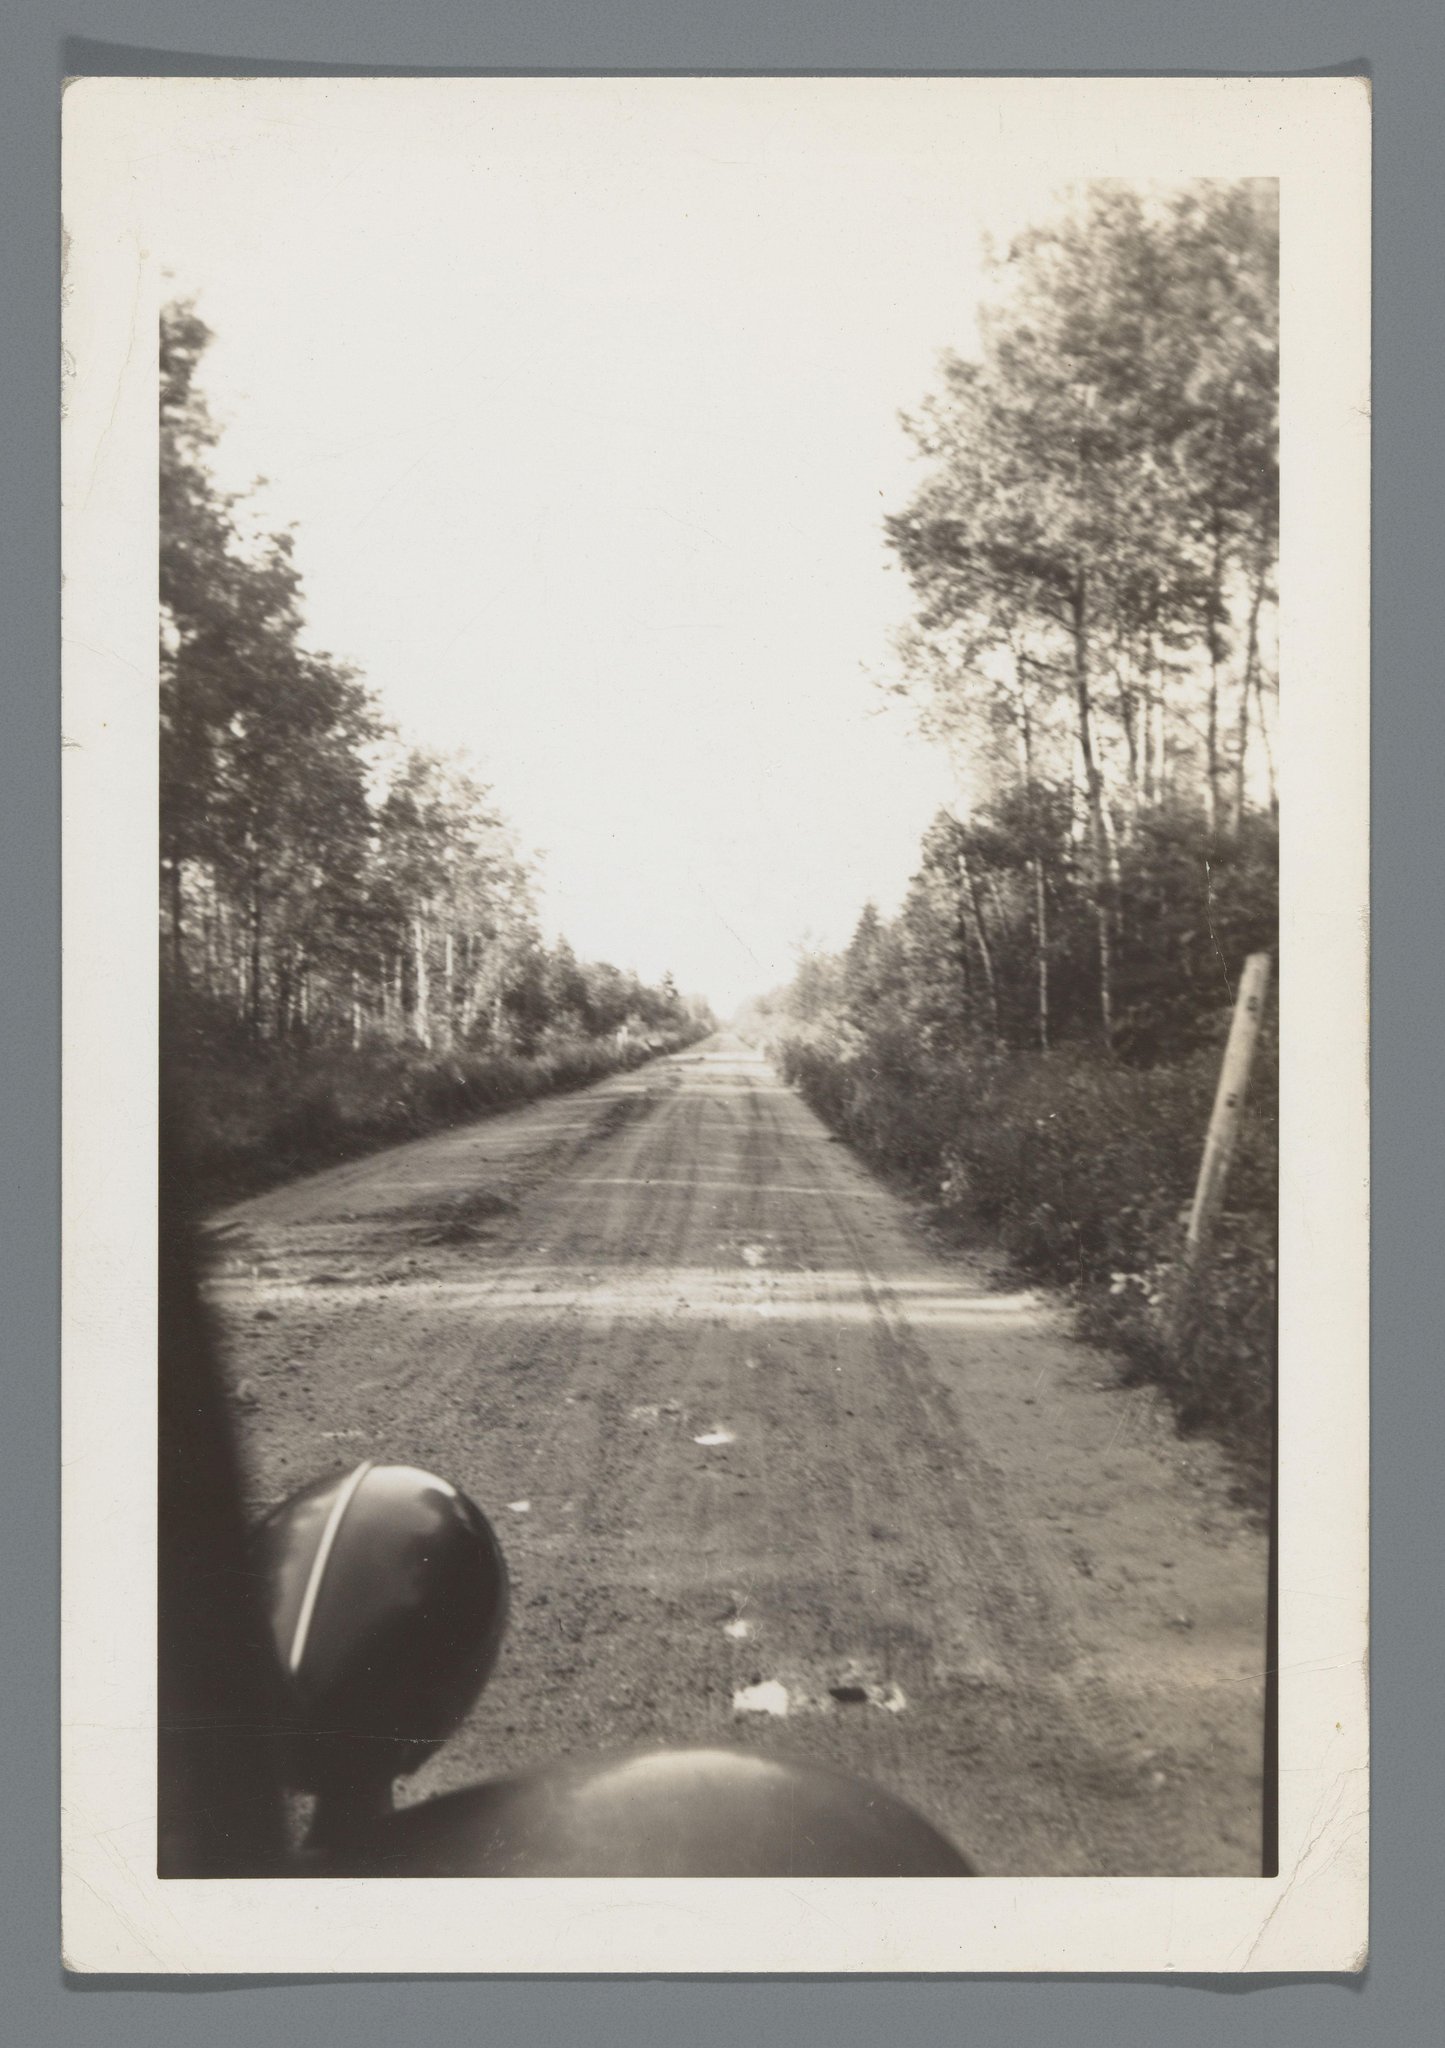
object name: photograph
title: Gezicht vanuit een rijdende auto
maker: Anonymous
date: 1908-1940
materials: paper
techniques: gelatin silver print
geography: united states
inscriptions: inscription: ‘Look close the/ deer or Dear is/ there.’, inscription: ‘911F’, inscription: ‘[…] AUG 9 1940’